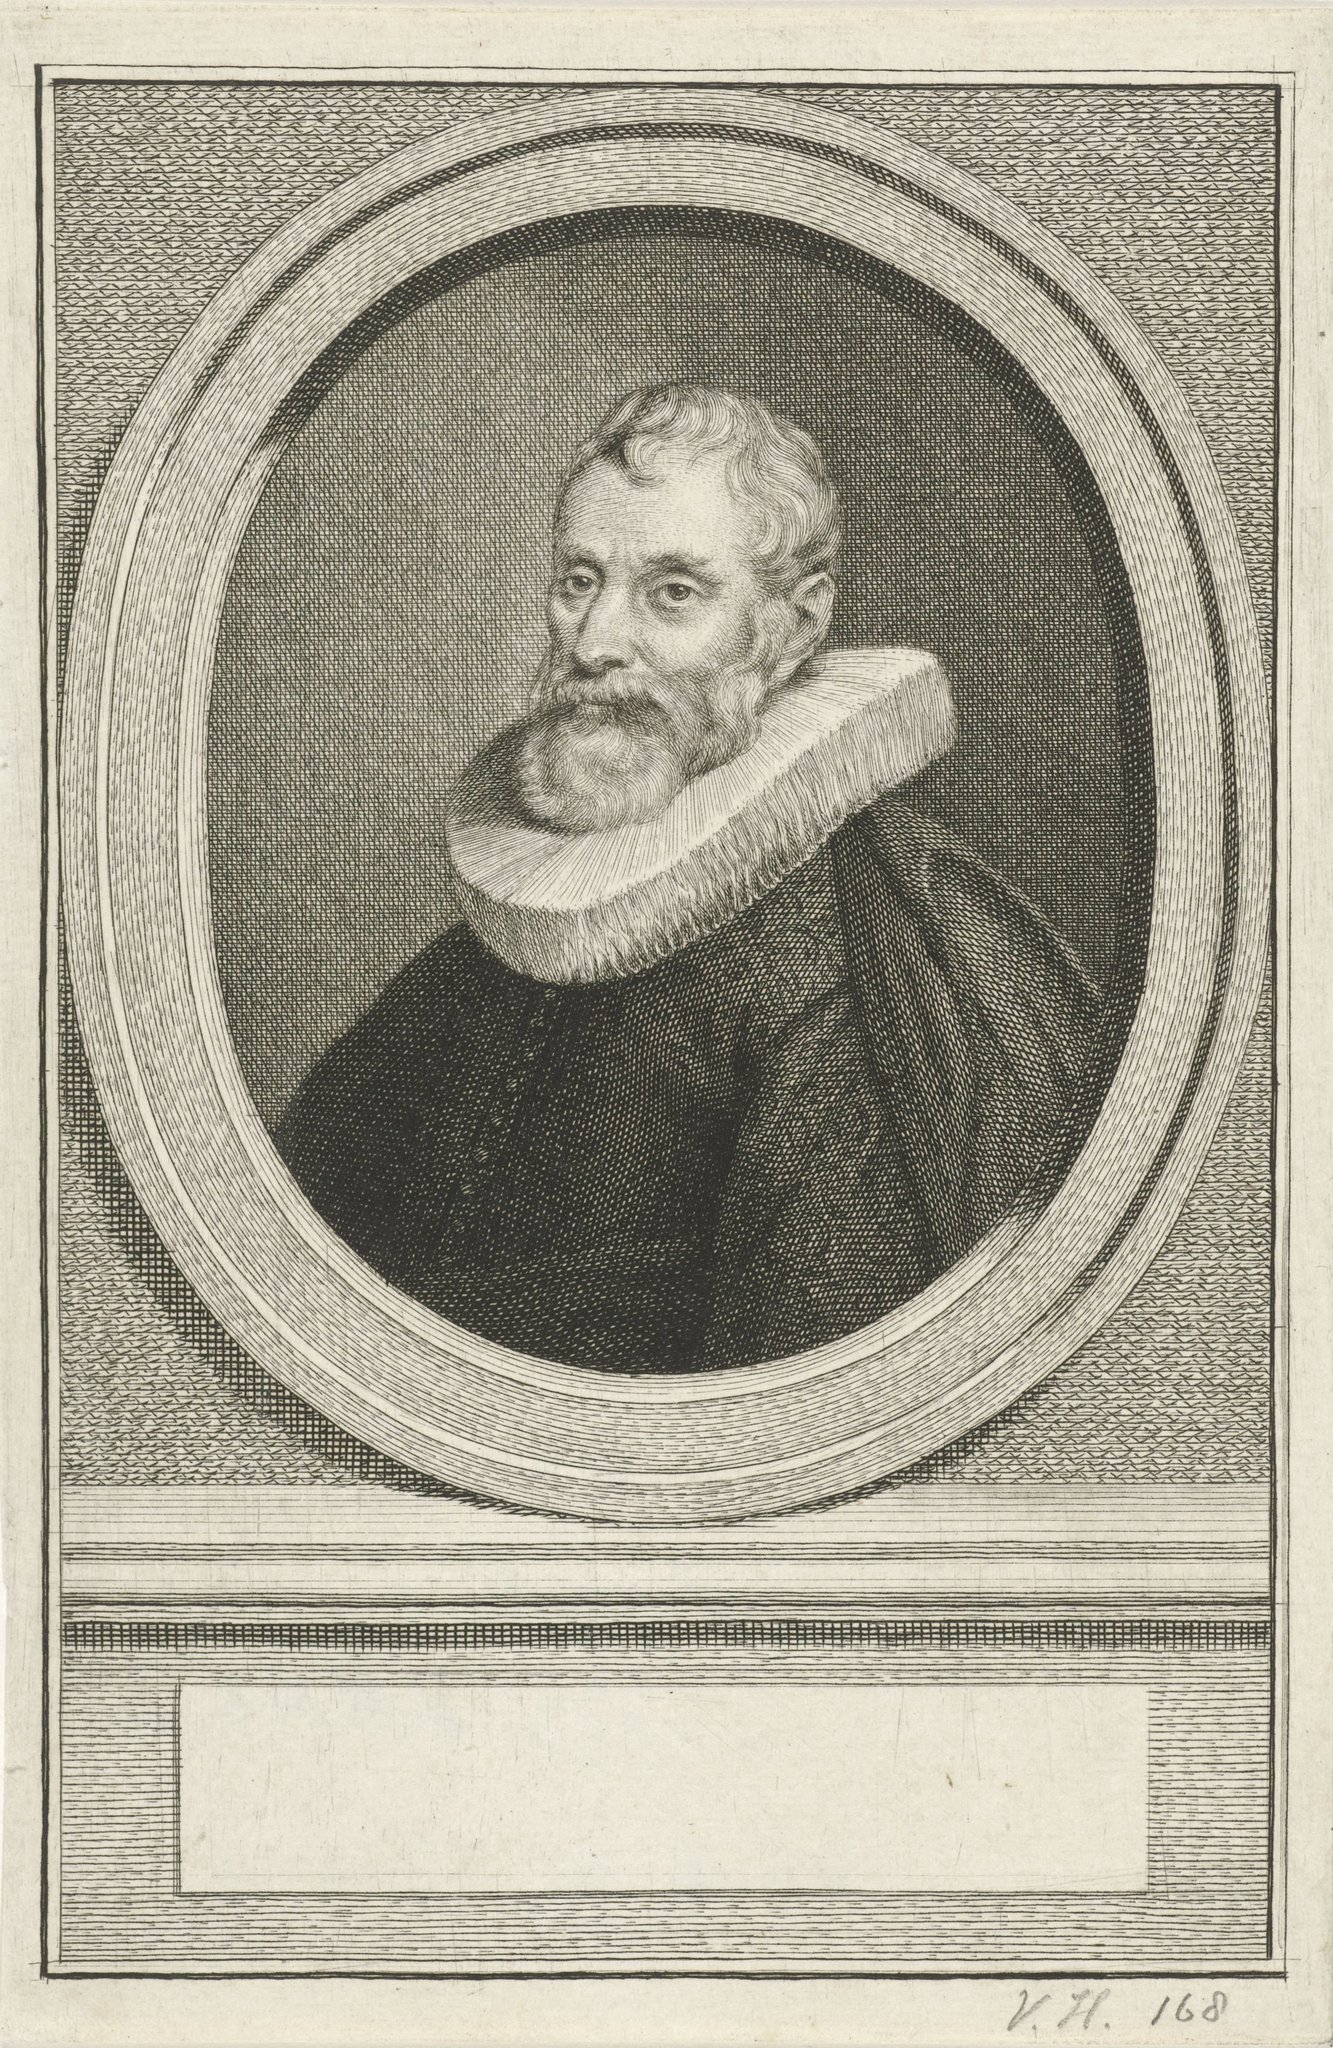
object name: print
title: Portret van Jacob Dirksz. de Graeff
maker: jacob houbraken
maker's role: draughtsman, print maker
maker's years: 1698-1780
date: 1749-1780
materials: paper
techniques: engraving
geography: amsterdam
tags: mayor, historical persons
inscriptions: collector's mark: Lugt 2228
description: Latere staat van deze prent is oorspronkelijk bedoeld als aanvulling op Jan Wagenaars ‘Vaderlandsche historie’* en was zo vanaf 1796 verkrijgbaar bij Johannes Allart te Amsterdam. Voor de advertentie waarin Allart de 60 portretten en 7 platen, allen gegraveerd door Houbraken, ter aanvulling op Wagenaars ‘Vaderlandsche historie’ aanbiedt, zie RP-P-OB-77.766. *Van dit werk zijn in de achttiende eeuw meerdere uitgaves verschenen, zoals: Wagenaar, Jan. Vaderlandsche historie, vervattende de geschiedenissen der Vereenigde Nederlanden (…). 21 delen. Amsterdam: Isaak Tirion, 1749-1759. Wagenaar, Jan. Vaderlandsche historie, vervattende de geschiedenissen der nu Vereenigde Nederlanden (…). 21 delen. Amsterdam: weduwe Isaak Tirion, 1770. Wagenaar, Jan. Vaderlandsche historie, vervattende de geschiedenissen der nu Vereenigde Nederlanden (…). 21 delen. Amsterdam, Leiden, Dordrecht en Harlingen: P. Schouten e.a., 1782. Wagenaar, Jan. Vaderlandsche historie, vervattende de geschiedenissen der nu Vereenigde Nederlanden (…). 21 delen. Amsterdam: Johannes Allart, 1790-1796.